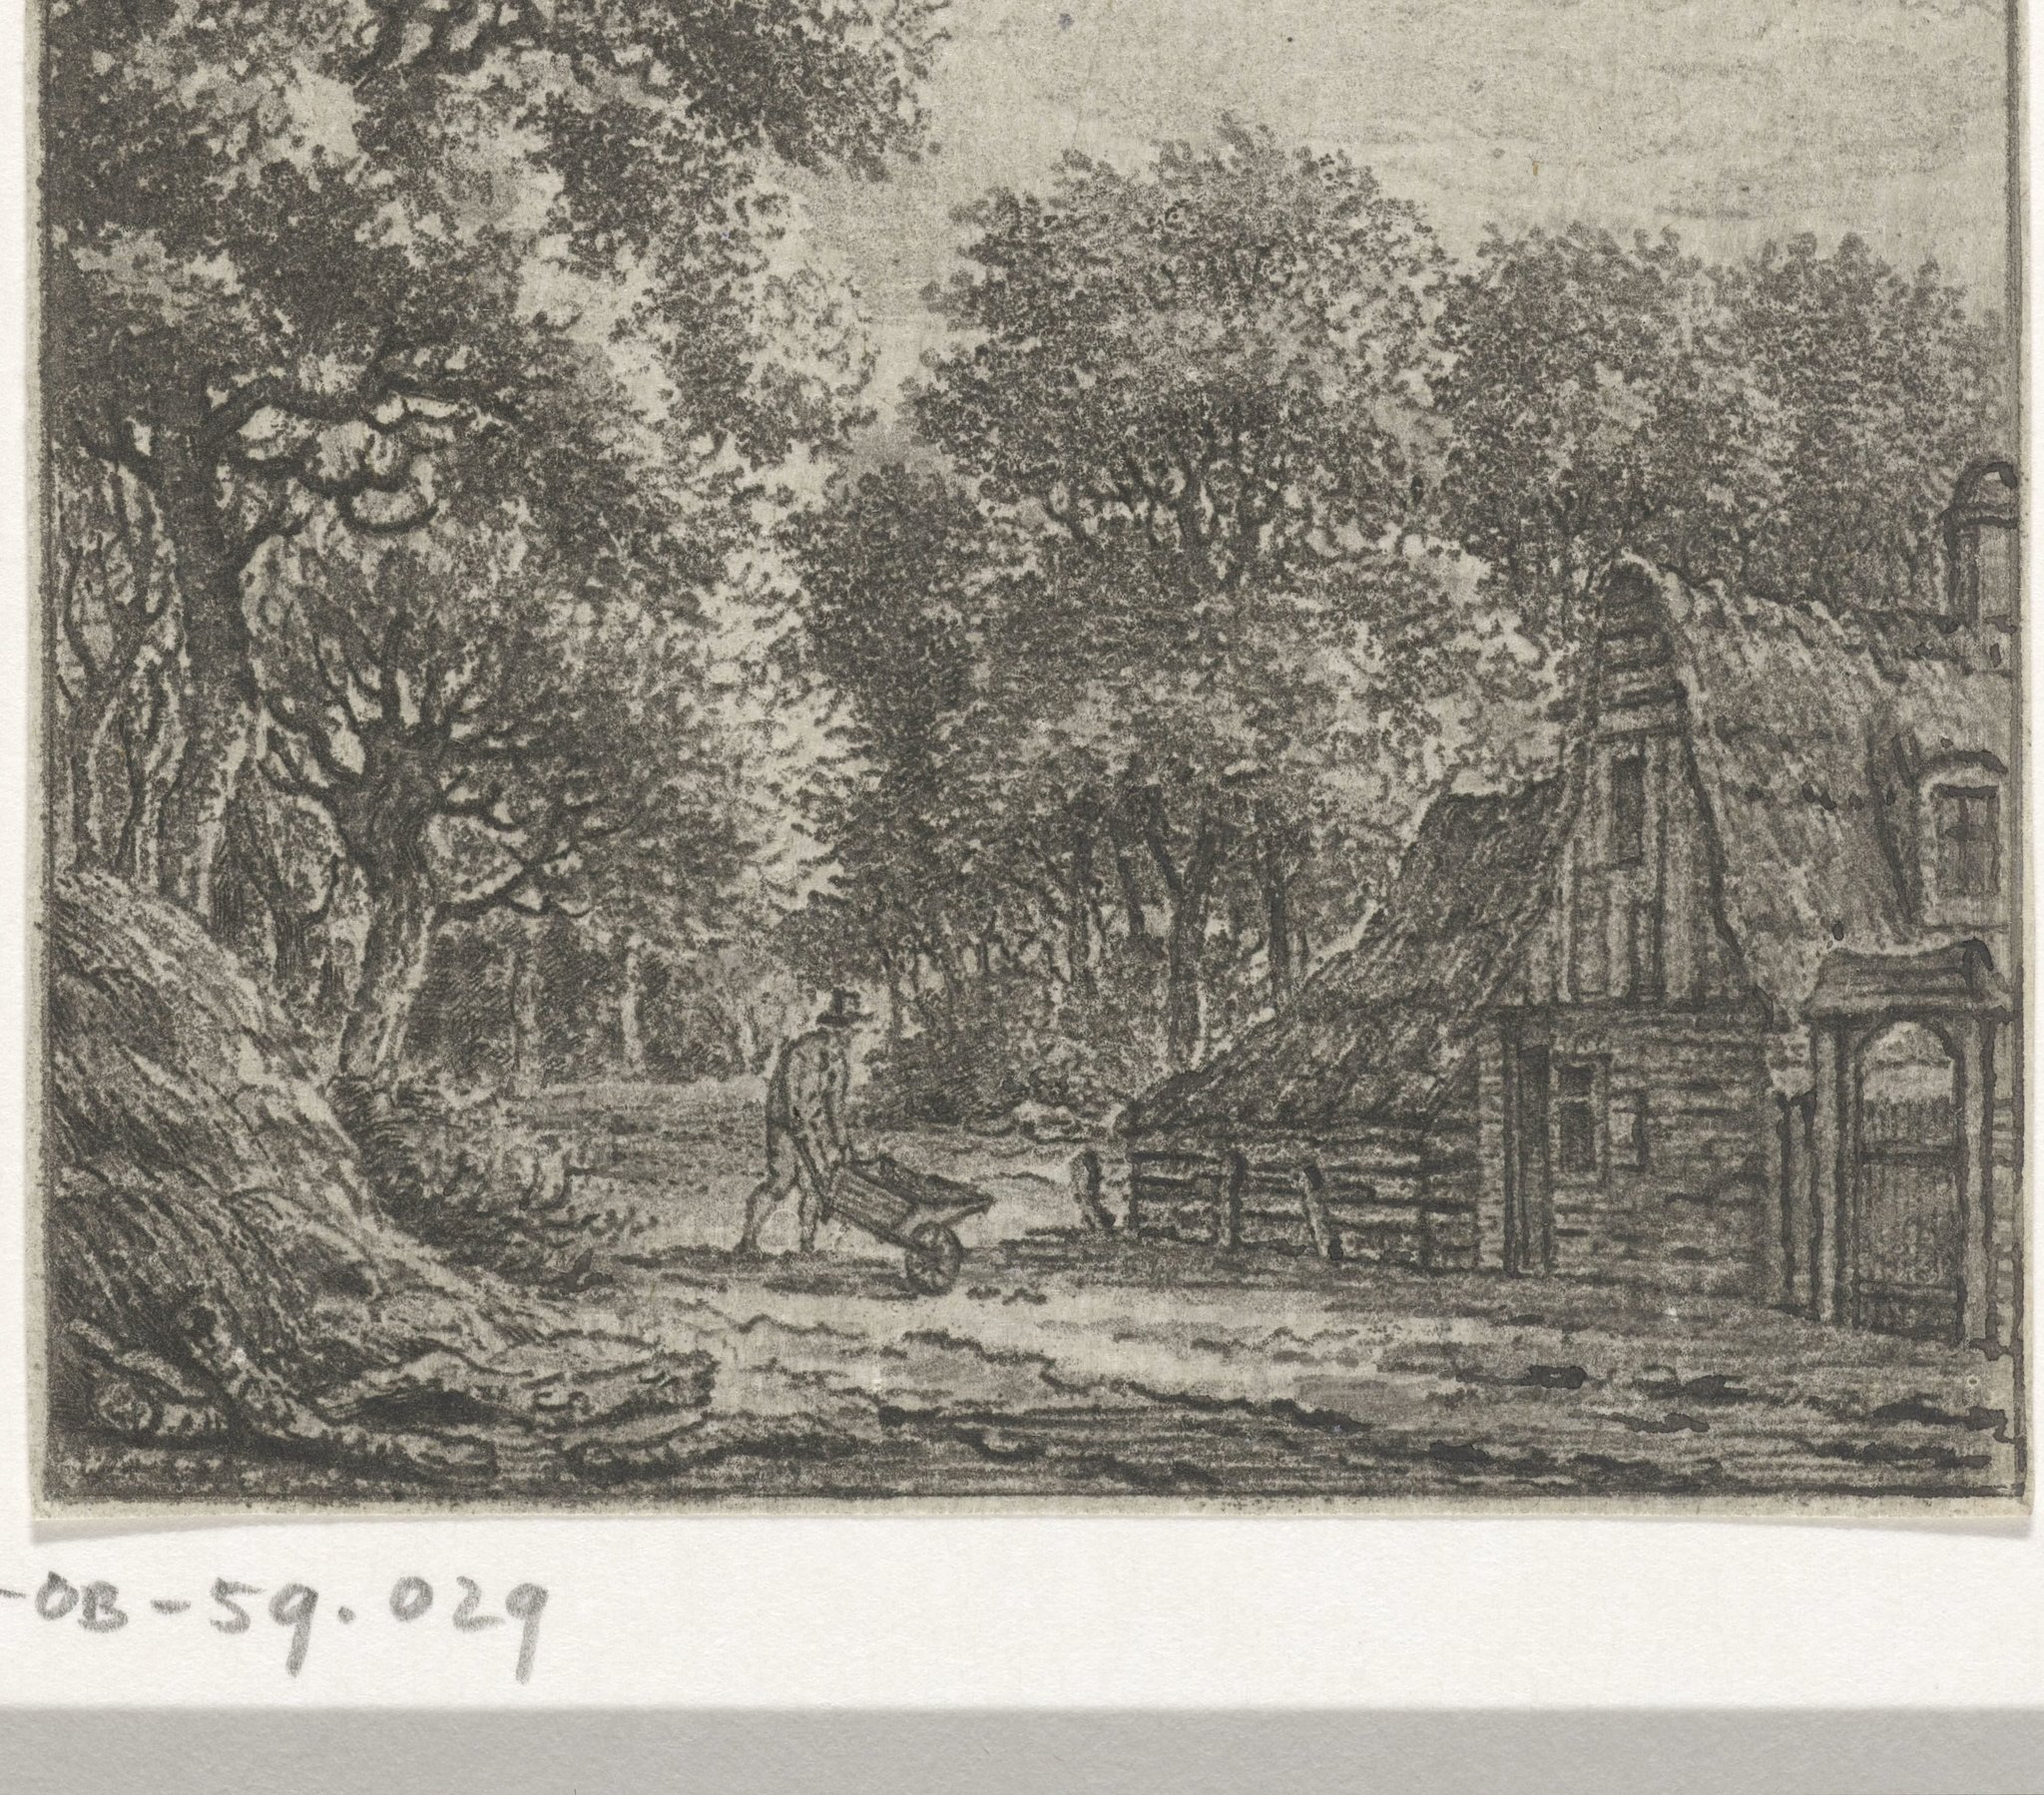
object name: print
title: Bebost landschap met boerderij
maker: jan evert grave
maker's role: draughtsman, print maker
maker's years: 1759-1805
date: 1786-1805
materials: paper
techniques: aquatint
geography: amsterdam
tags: wheelbarrow, forest, wood (+ landscape with figures, staffage), farm or solitary house in landscape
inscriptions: collector's mark: Lugt 2228, caption: ‘J.E. Grave’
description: Een boerderij aan de rand van het bos. In het midden een man met een kruiwagen.